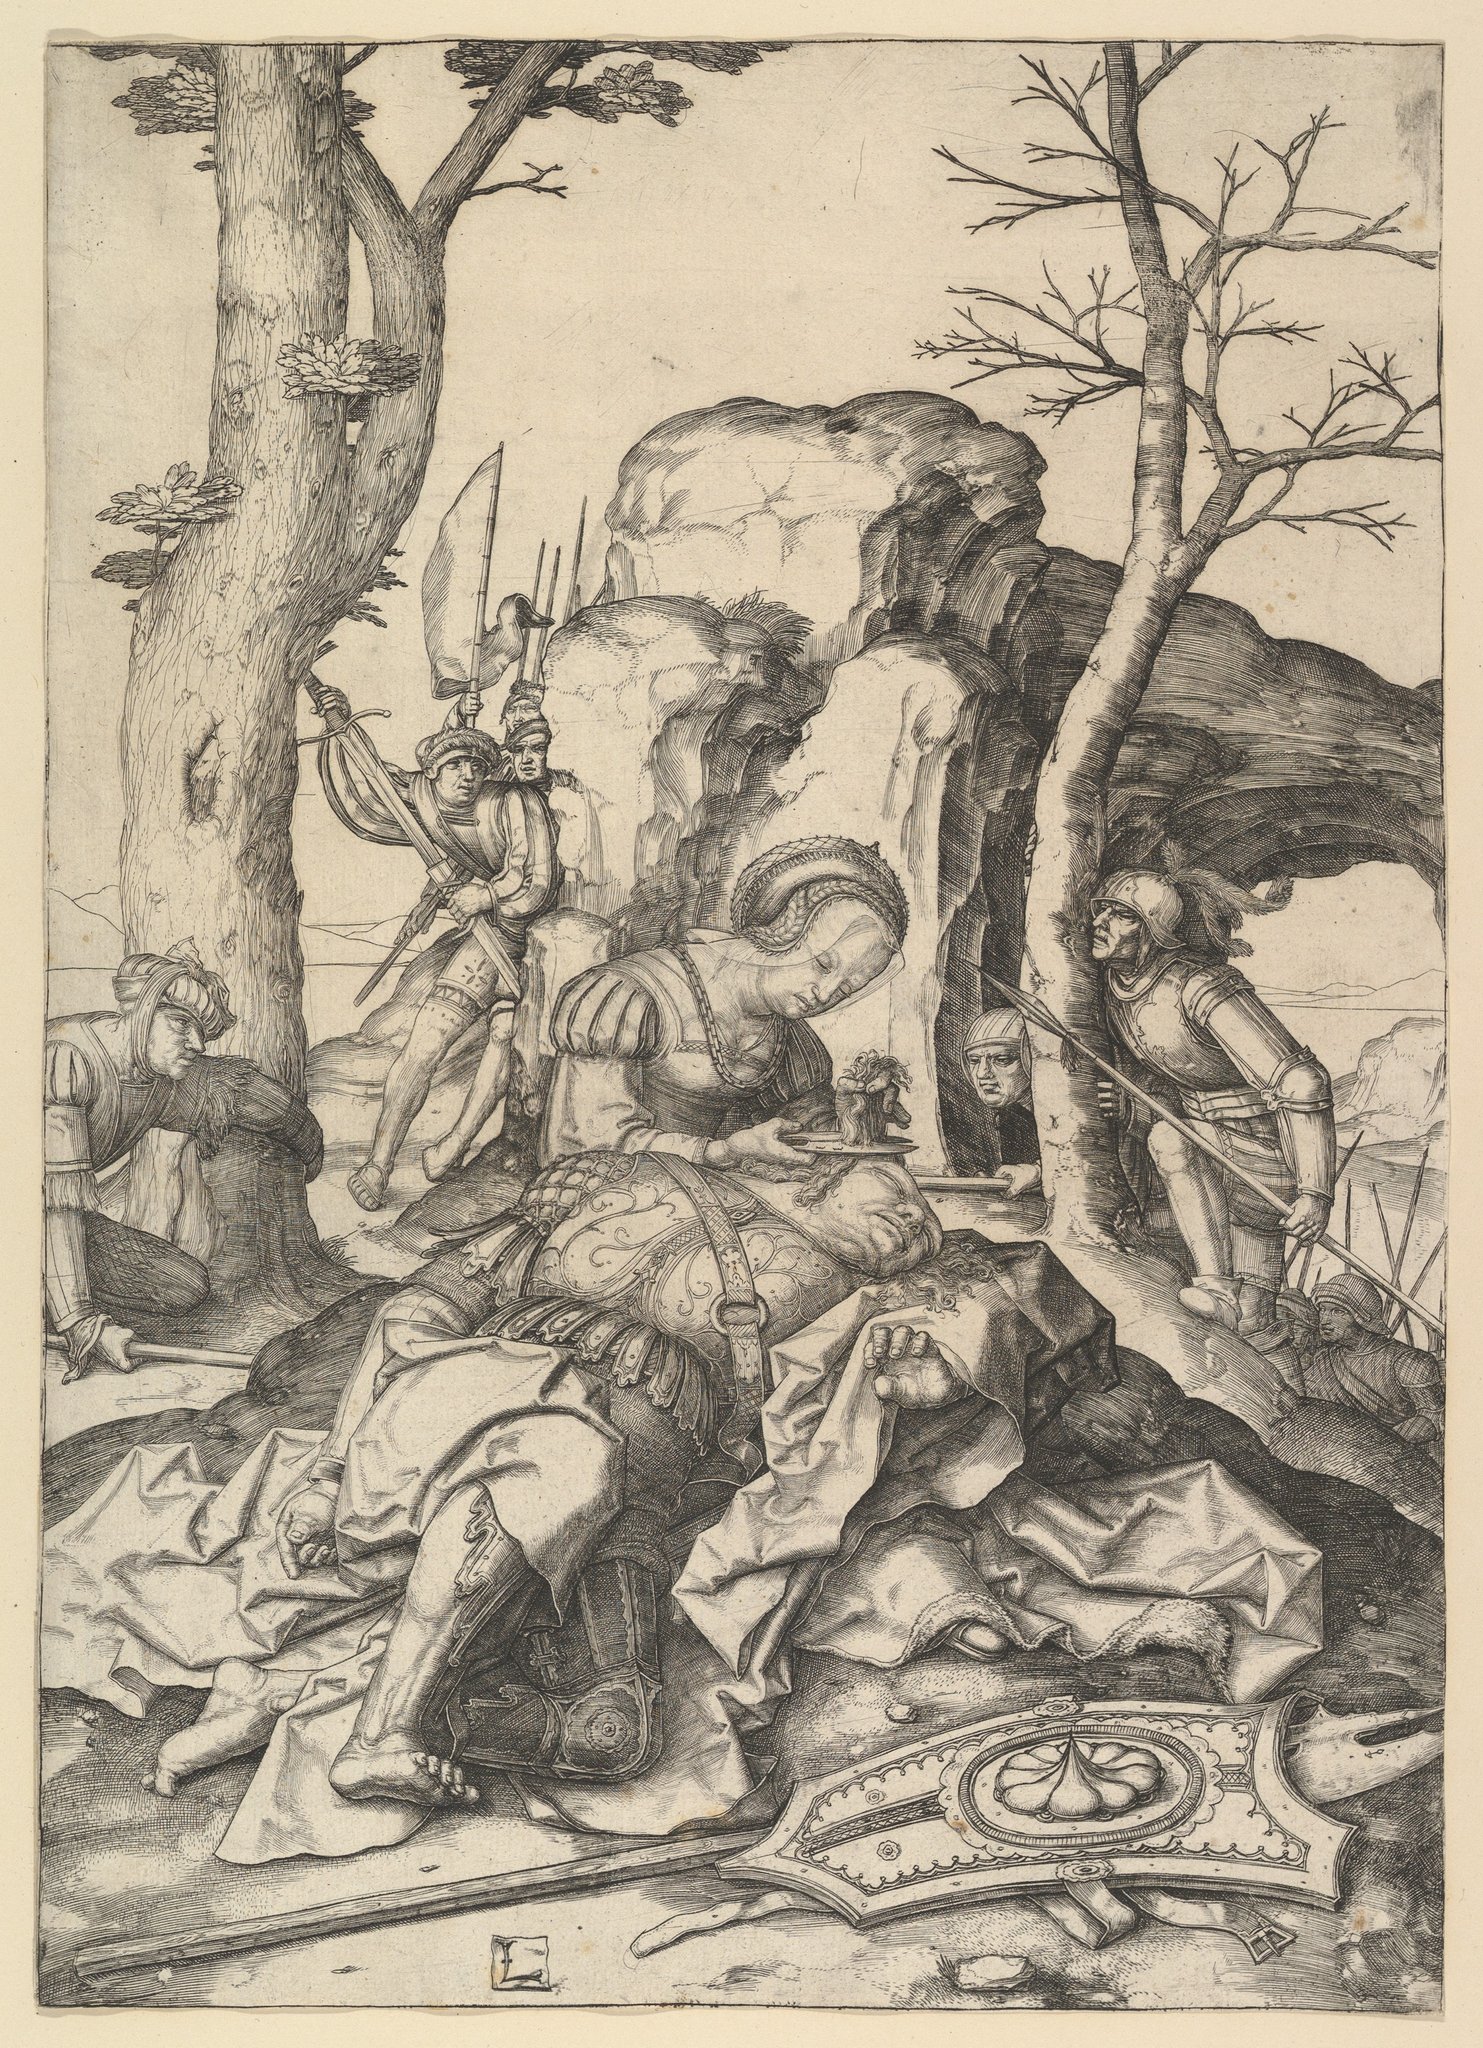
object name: print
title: Samson and Delilah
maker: lucas van leyden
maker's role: artist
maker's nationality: netherlandish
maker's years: 1494-1533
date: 1507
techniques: engraving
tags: soldiers,weapons,women,samson,death